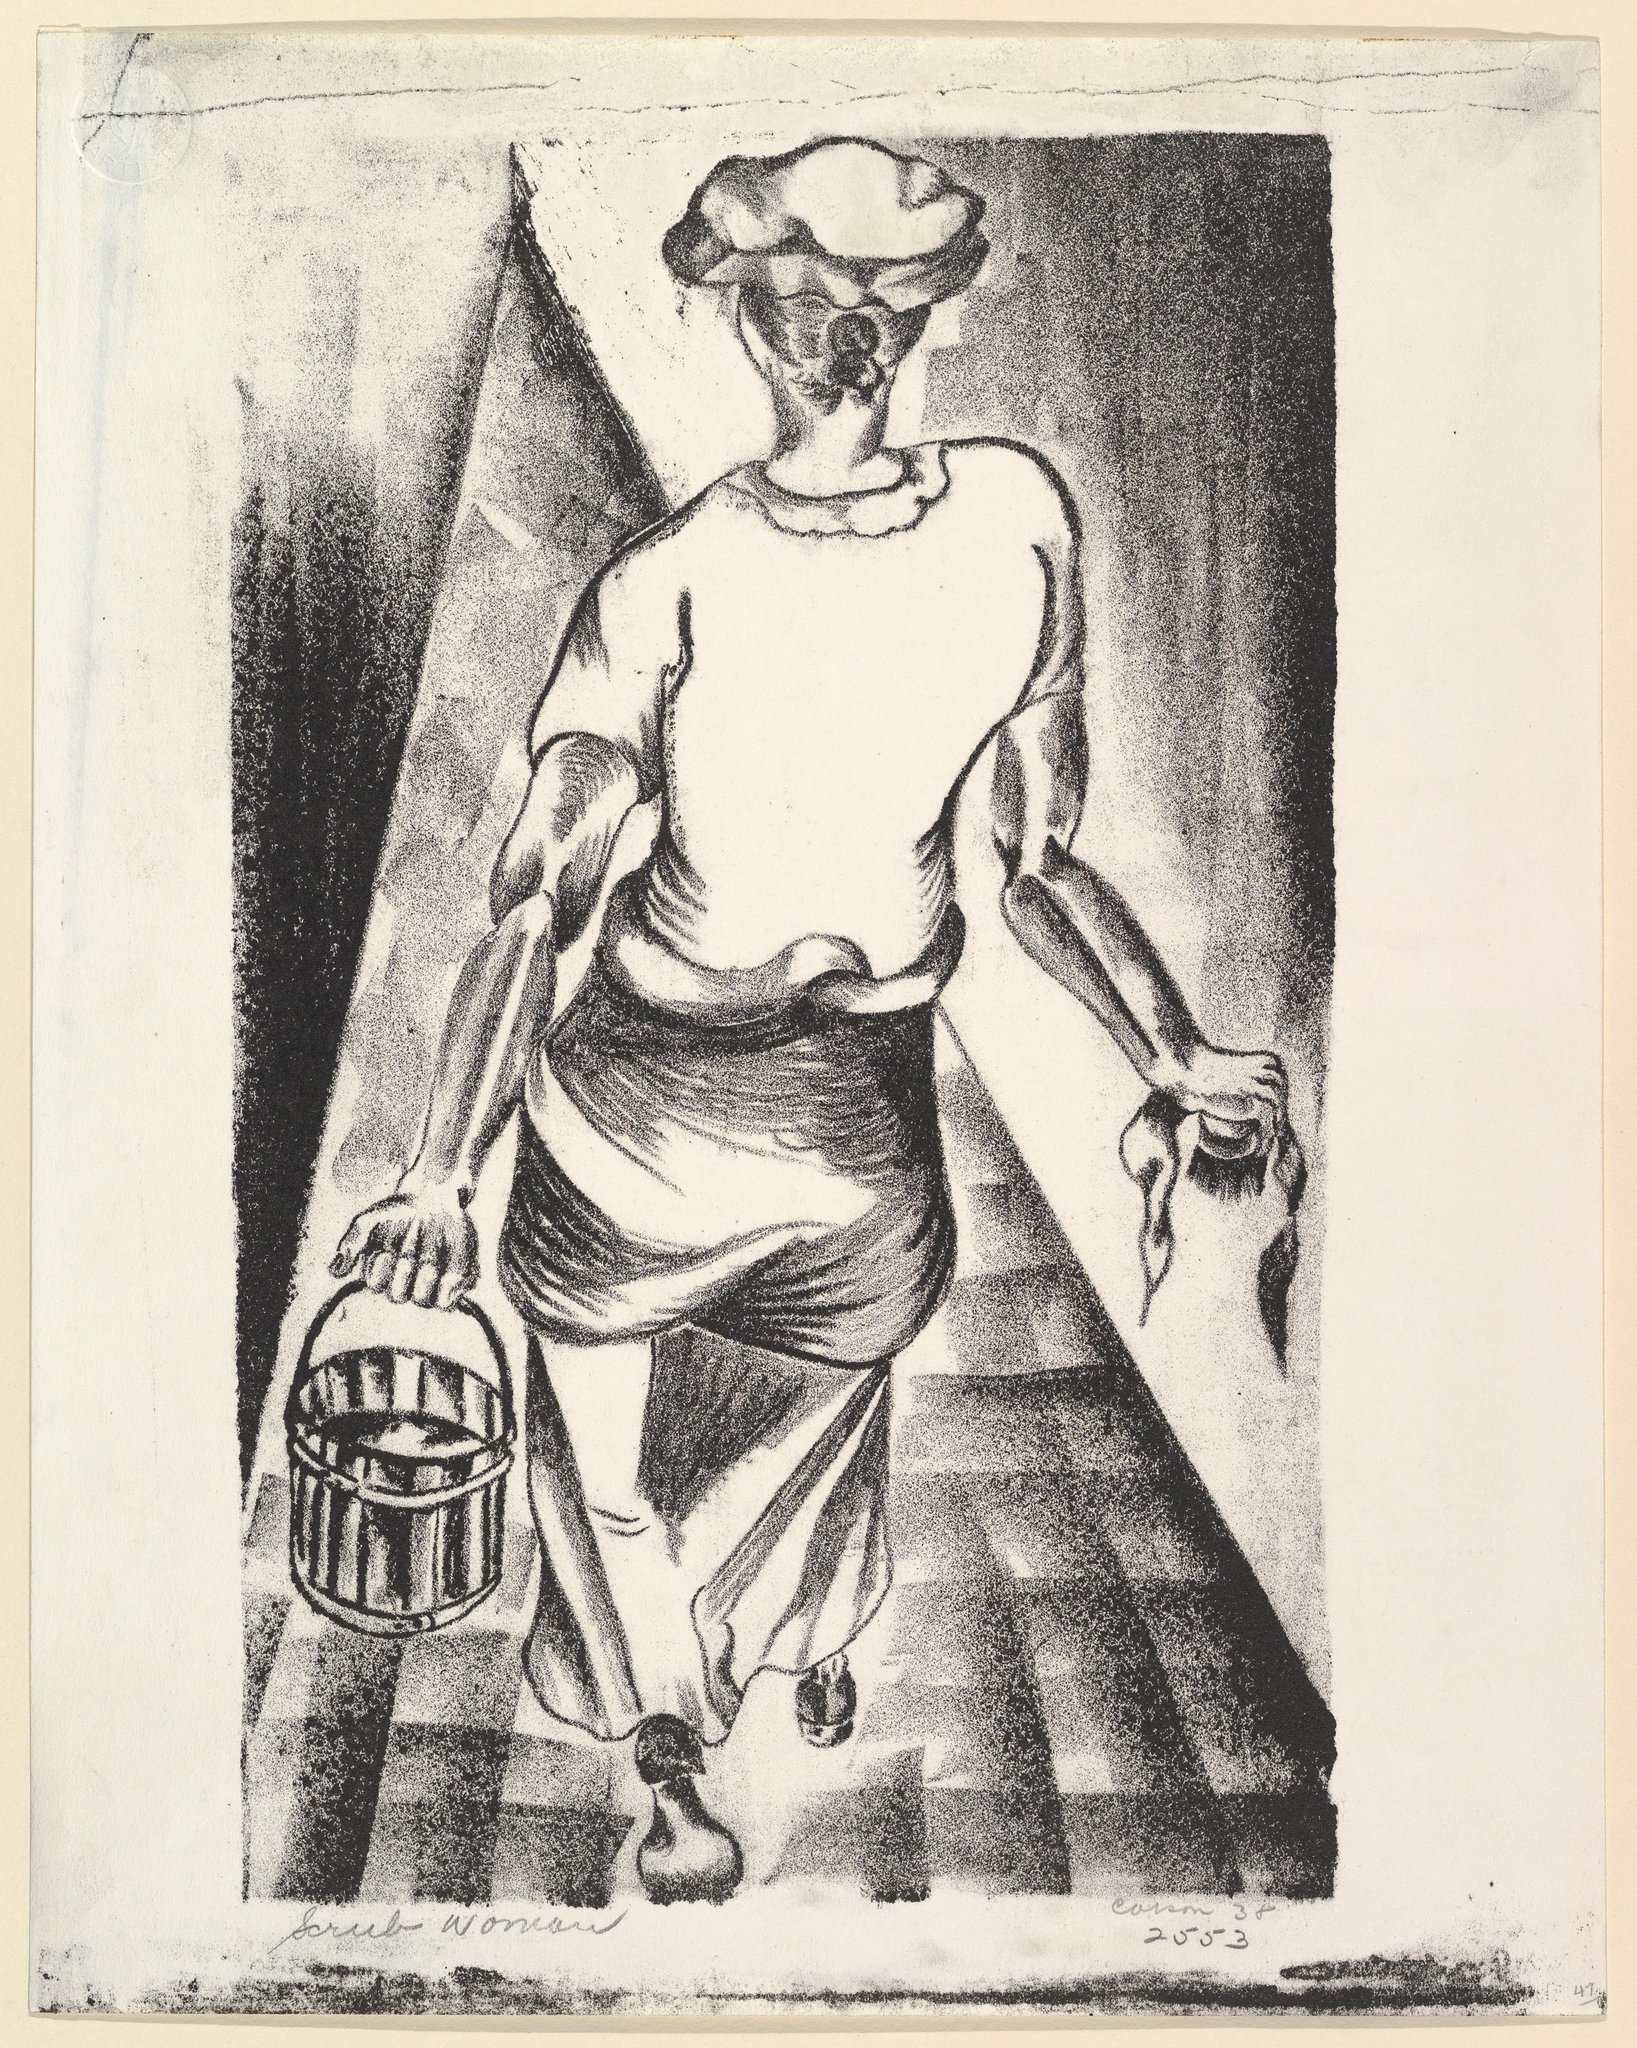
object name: print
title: Scrub Woman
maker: cliffa corson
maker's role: artist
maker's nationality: american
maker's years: 1907-2002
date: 1938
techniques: lithograph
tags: women